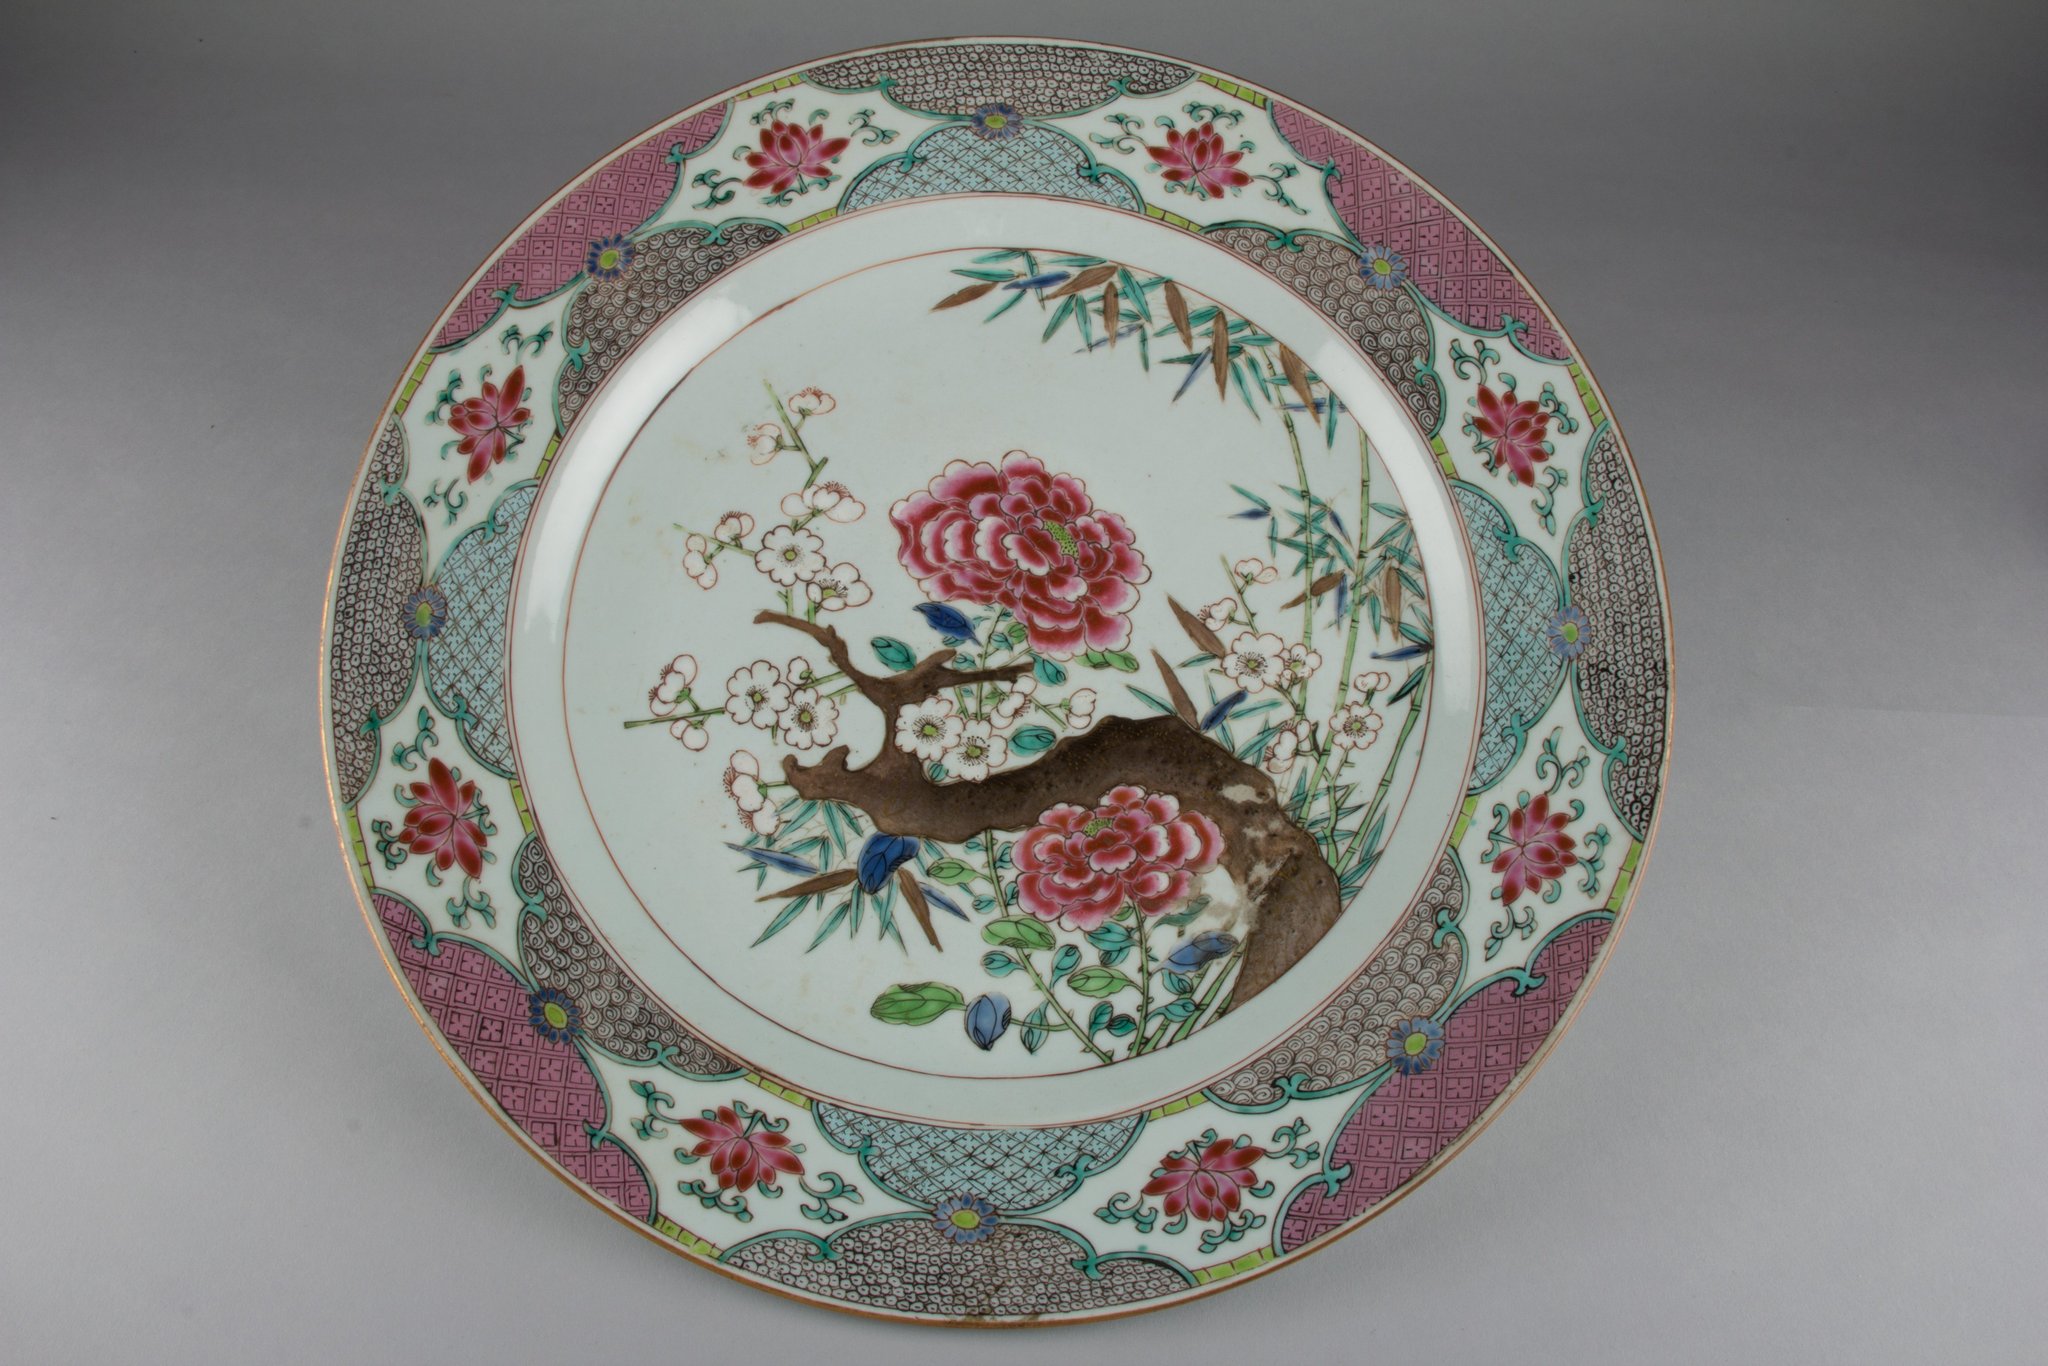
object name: dish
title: Dish with plants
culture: chinese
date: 1767-1800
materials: enamel, porcelain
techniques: overglaze, painting, polychrome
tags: flowers